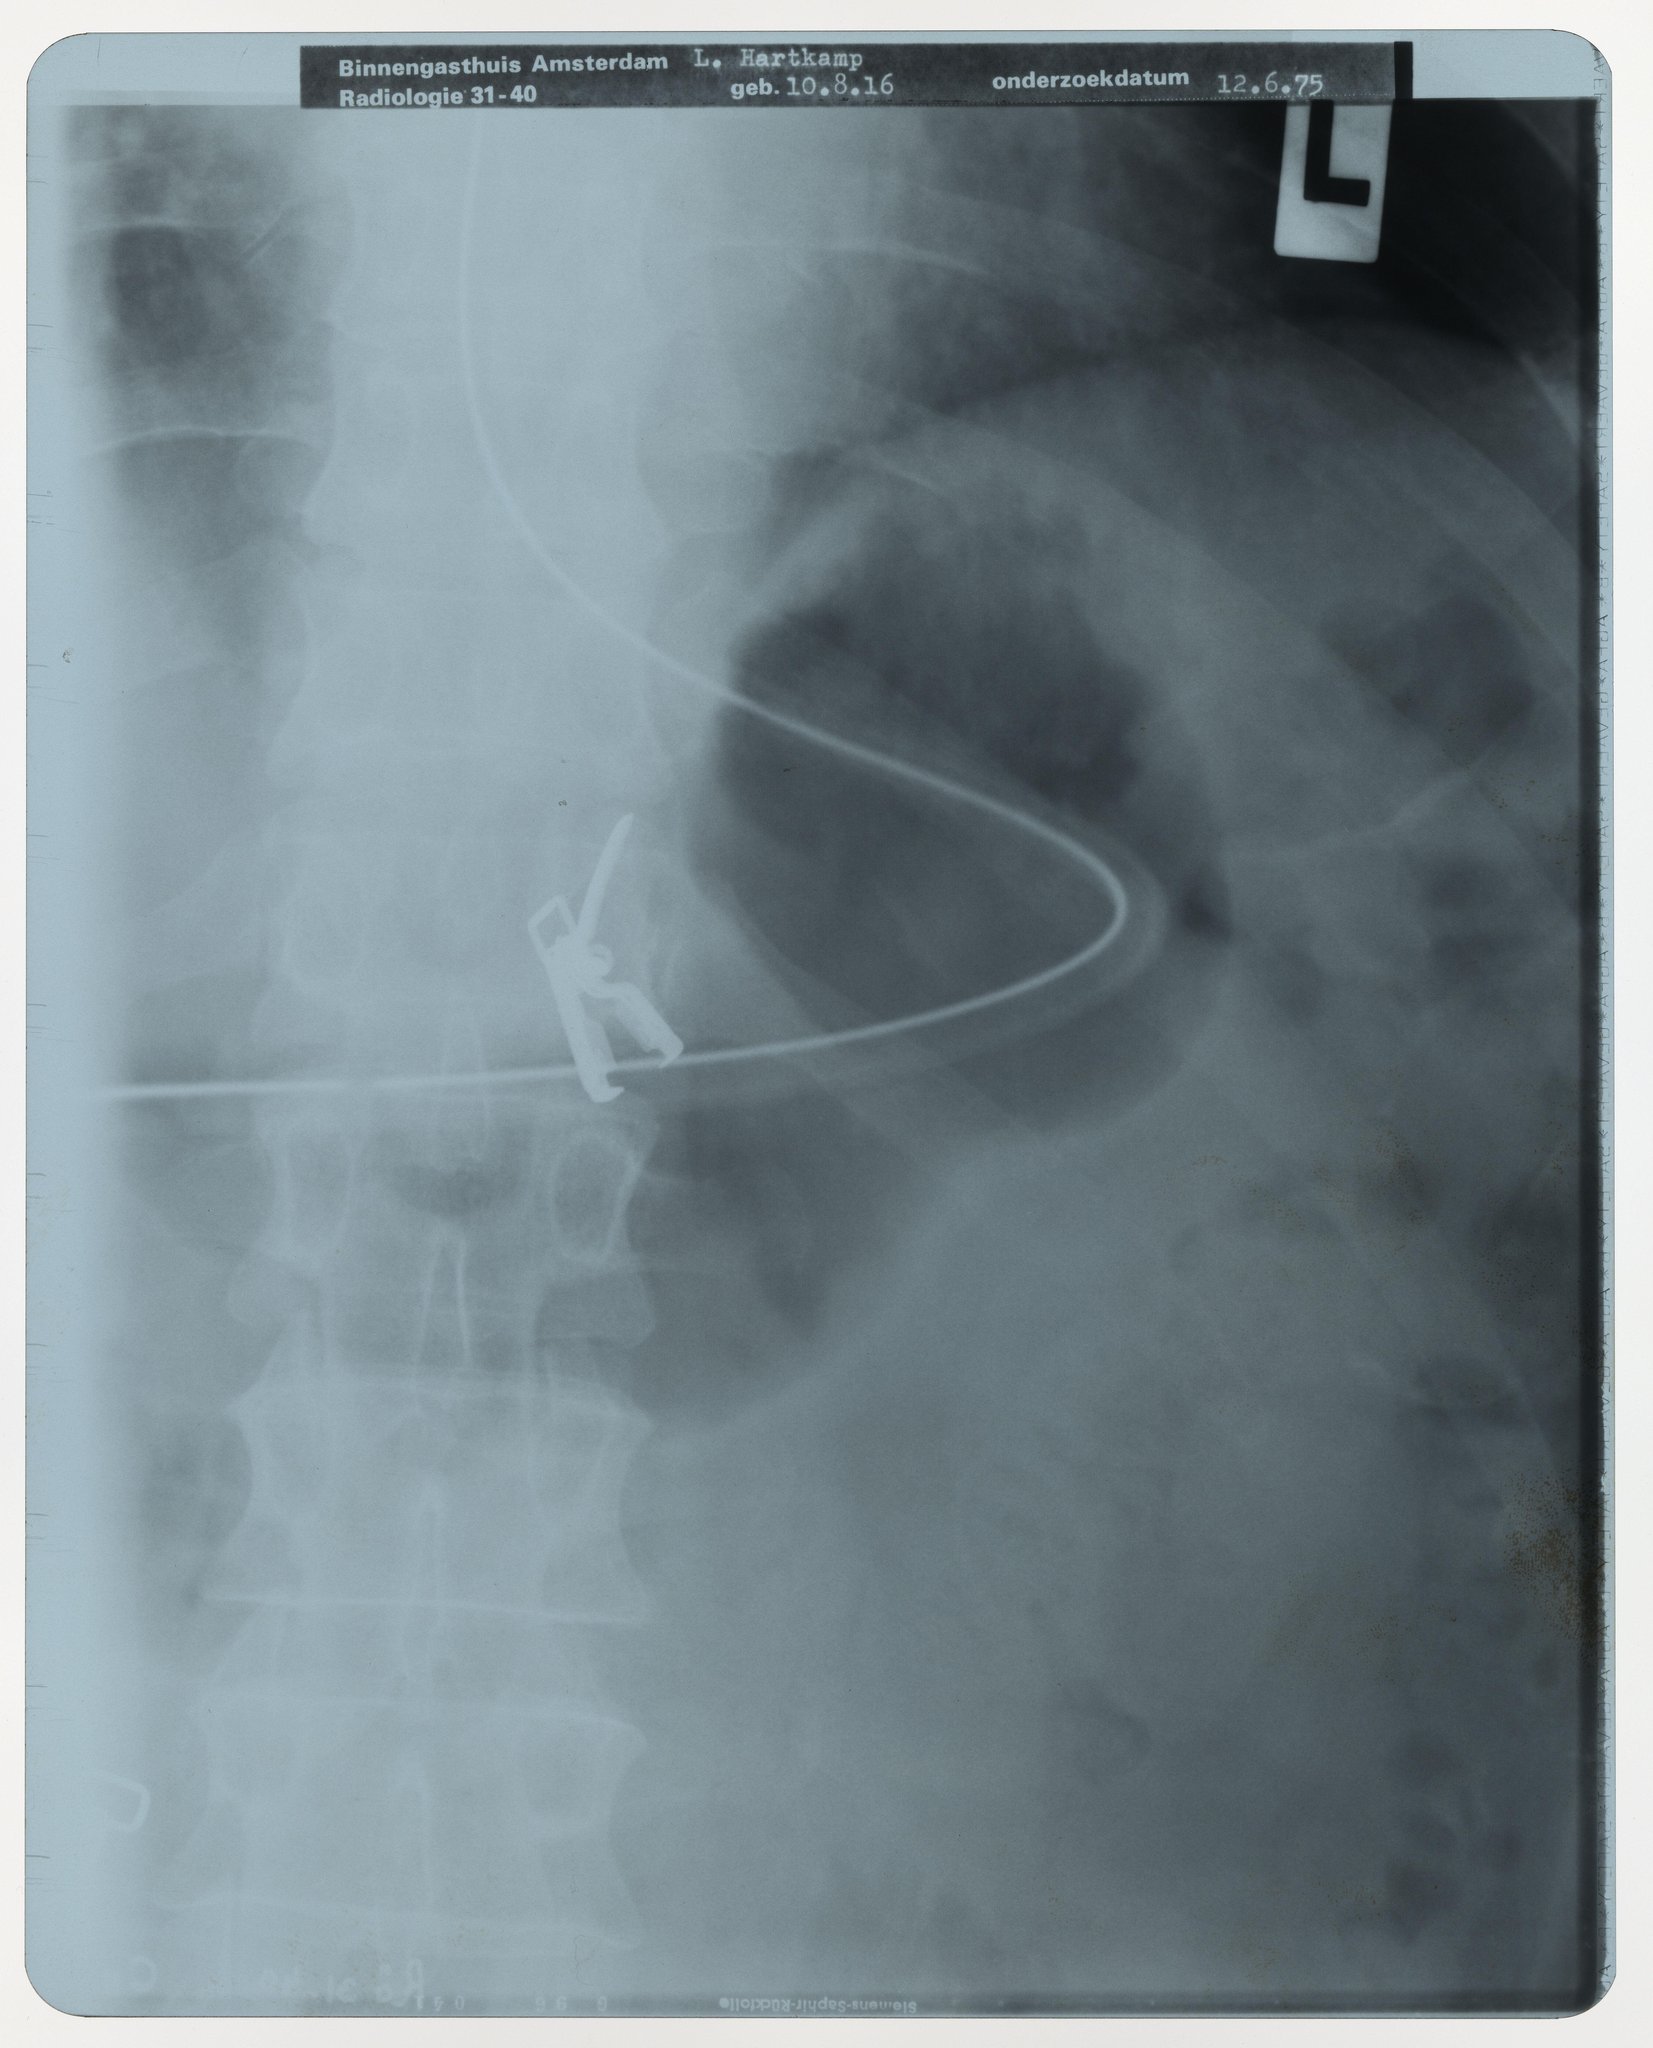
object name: x ray photograph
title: Röntgenopname van de maag van Bert Hartkamp, voorafgaand aan het uithevelen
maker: Anonymous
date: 1975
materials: plastic, film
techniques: gelatin silver negative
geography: amsterdam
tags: l.j. hartkamp, stomach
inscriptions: inscription: ‘foto voorafgaand aan/ uithevelen maag/ [...]/ of slang op/ juiste diepte zit’